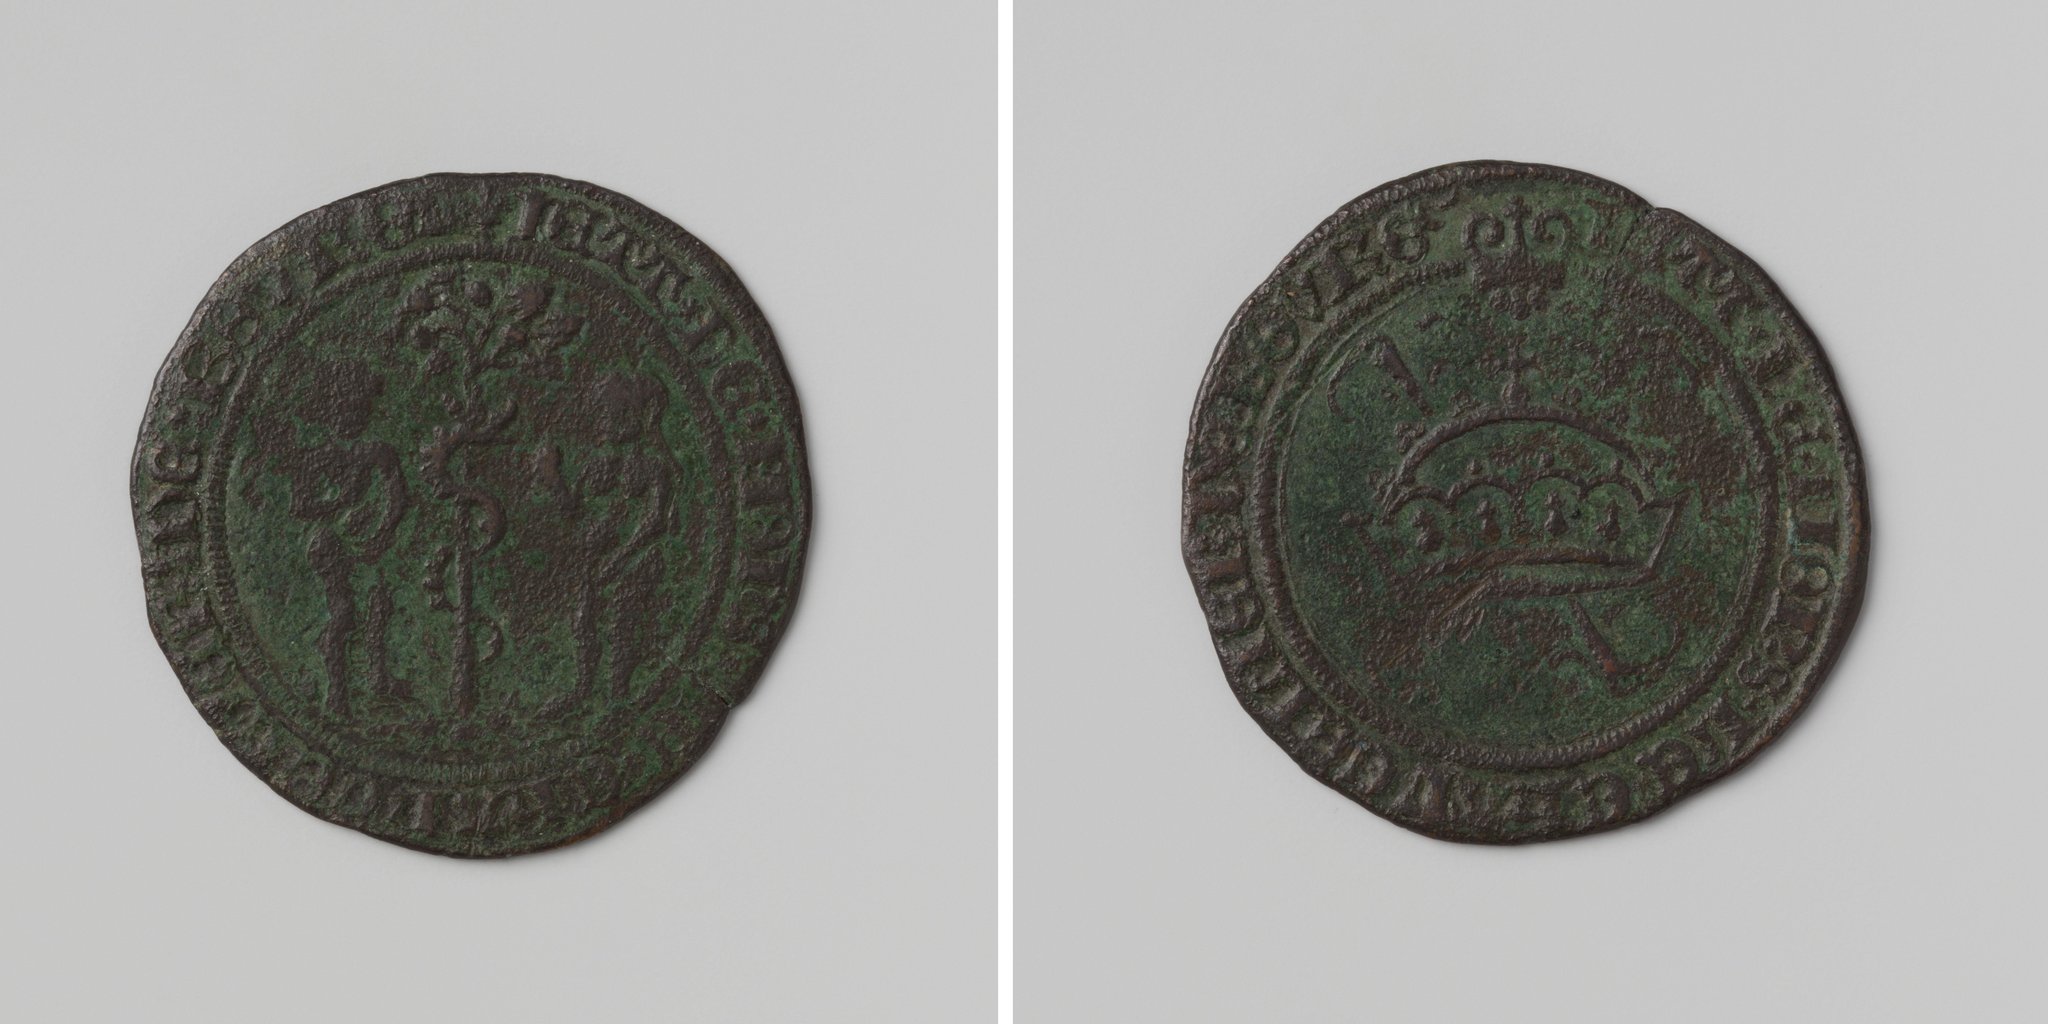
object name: jeton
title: Filips de Schone, hertog van Bourgondie, rekenpenning van de kanselier van Bourgondie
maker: Anonymous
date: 1491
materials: copper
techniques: striking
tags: bruges, filips de schone (hertog van bourgondië)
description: Koperen penning. Voorzijde: naakte man en vrouw, voorstellende, Adam en Eva, staande aan weerszijden van boom, waar slang omheen gekronkeld is binnen omschrift. Keerzijde: Bourgondisch kruis binnen kroon, binnen omschrift.